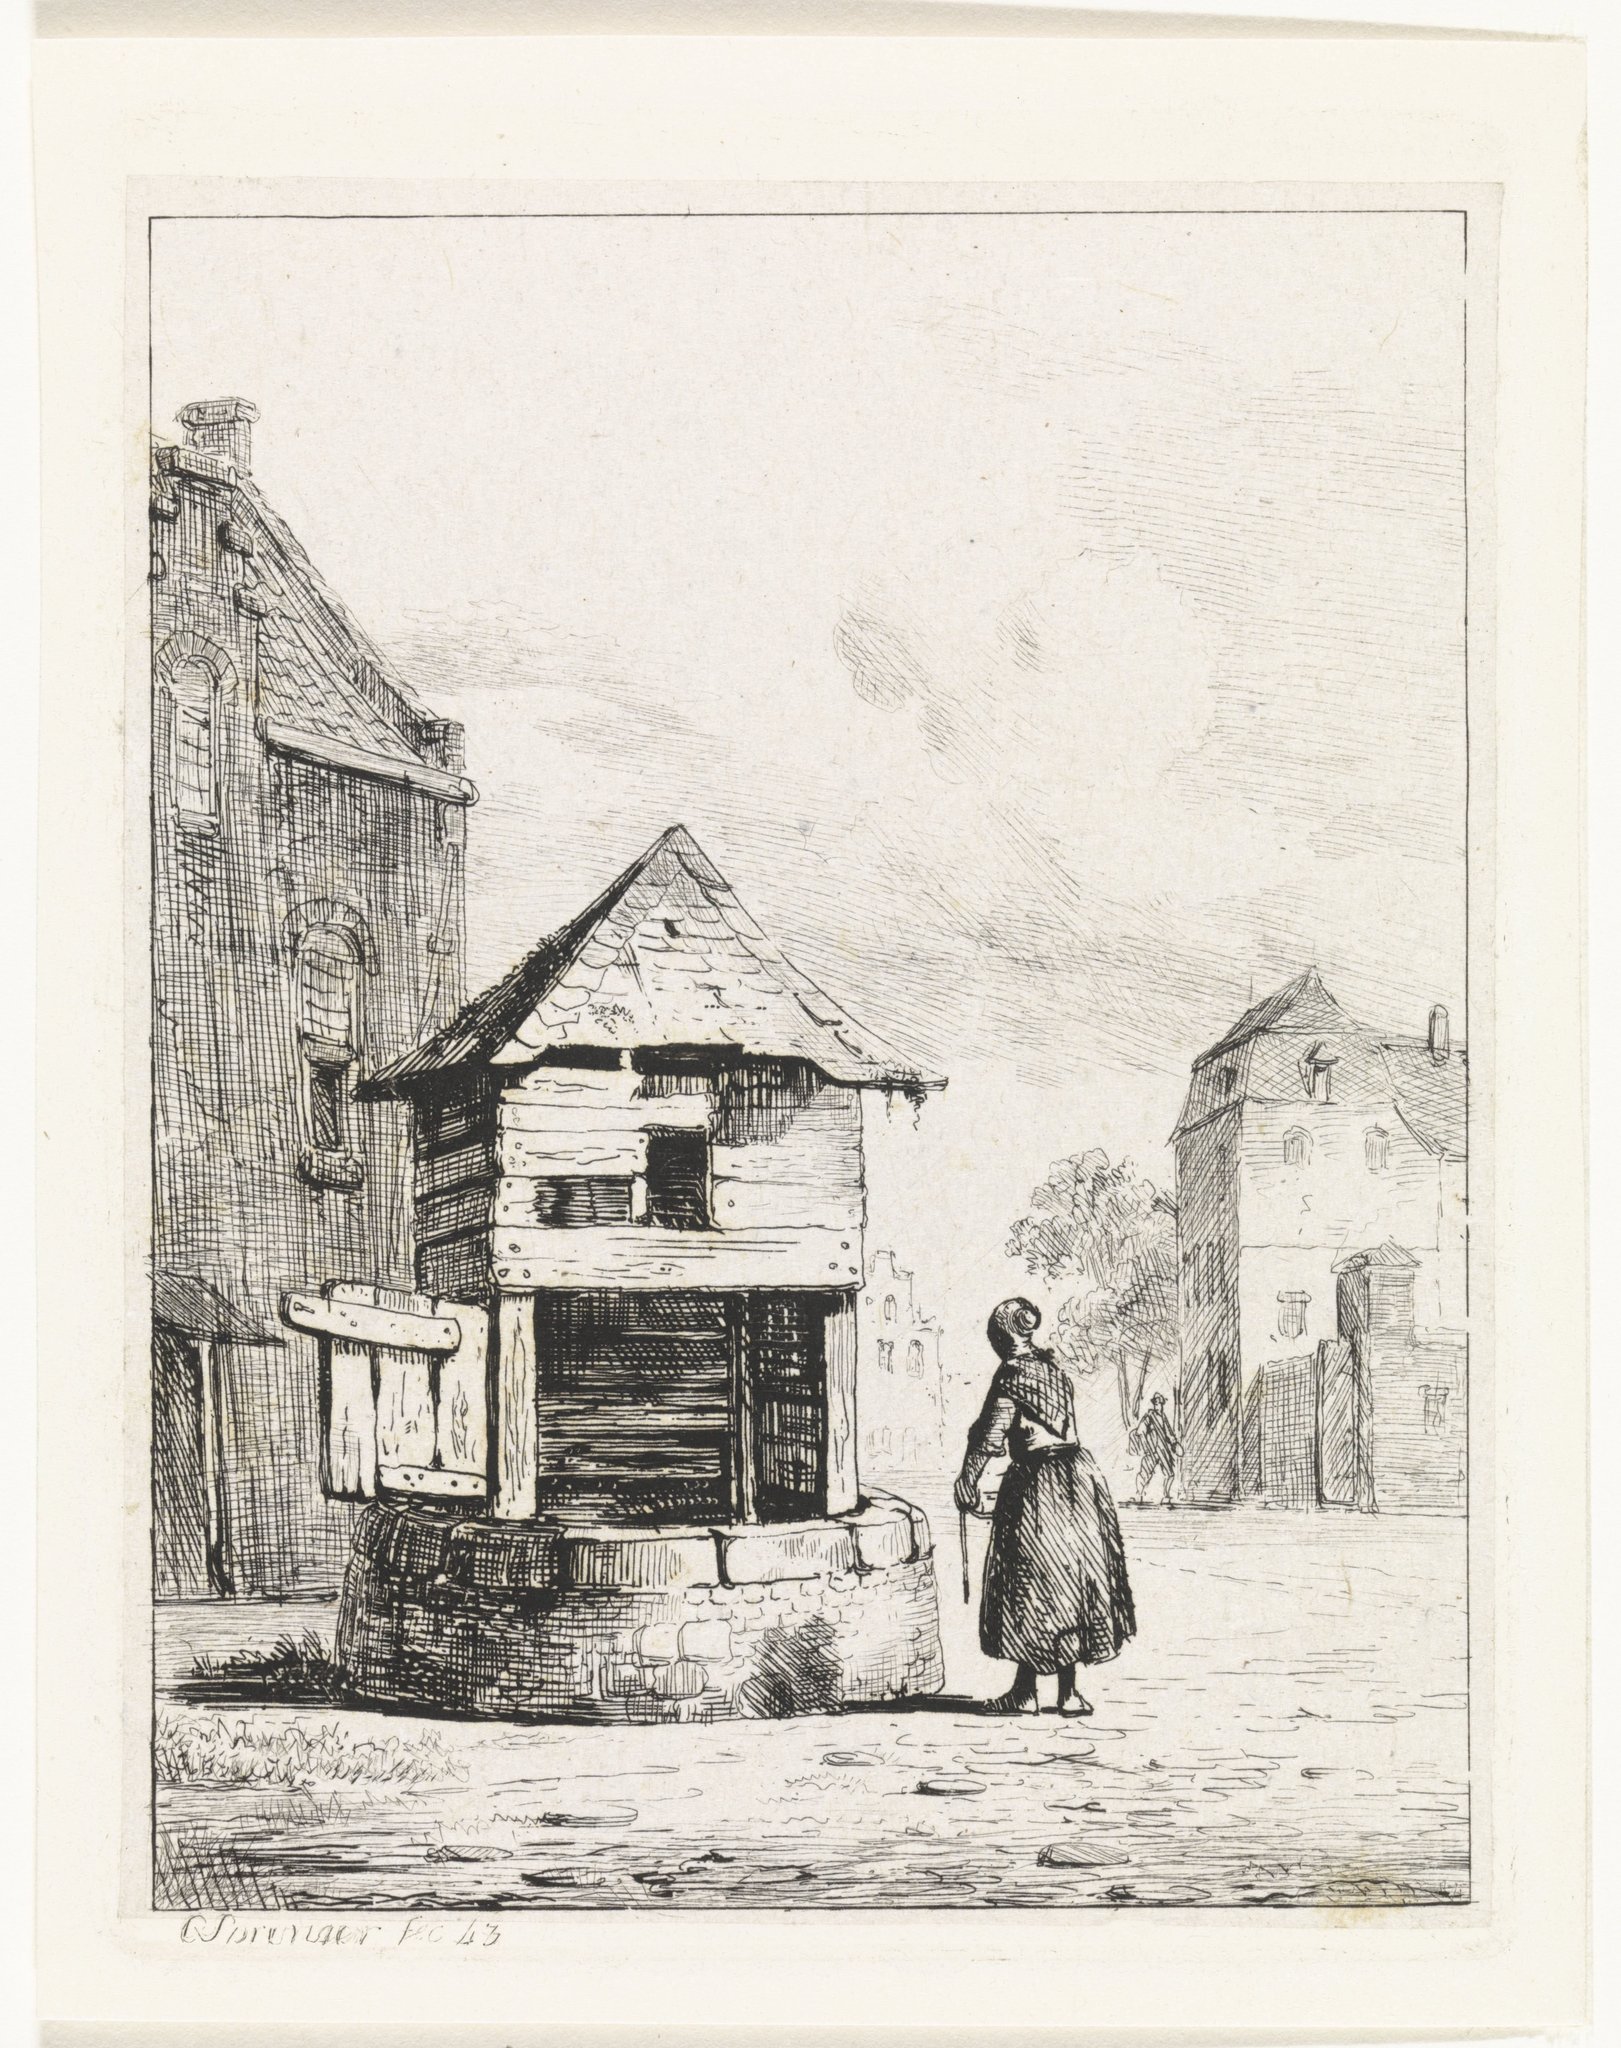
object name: print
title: Meisje bij een waterput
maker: cornelis springer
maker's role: draughtsman, painter, print maker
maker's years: 1817-1891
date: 1843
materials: paper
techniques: etching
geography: amsterdam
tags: well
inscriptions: collector's mark: Lugt 2228